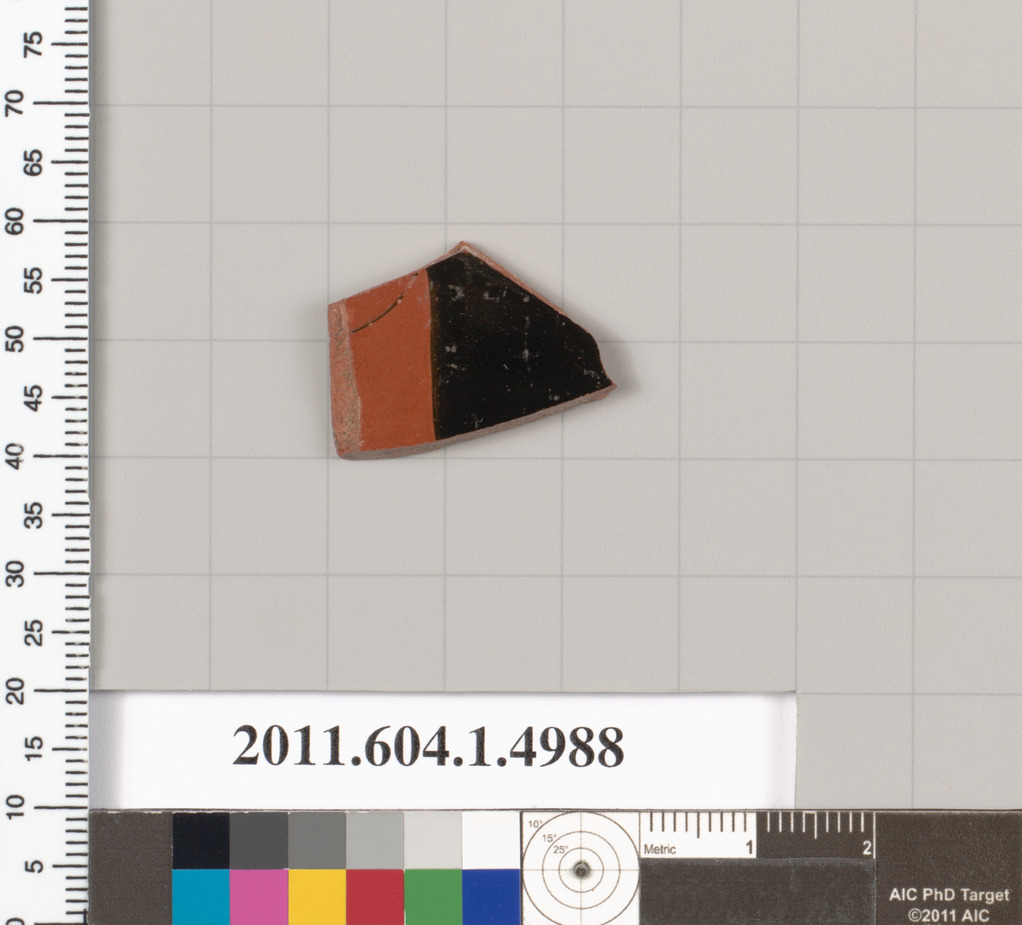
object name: kylix fragment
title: Terracotta fragment of a kylix (drinking cup)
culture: greek, attic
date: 475-451 BCE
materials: terracotta